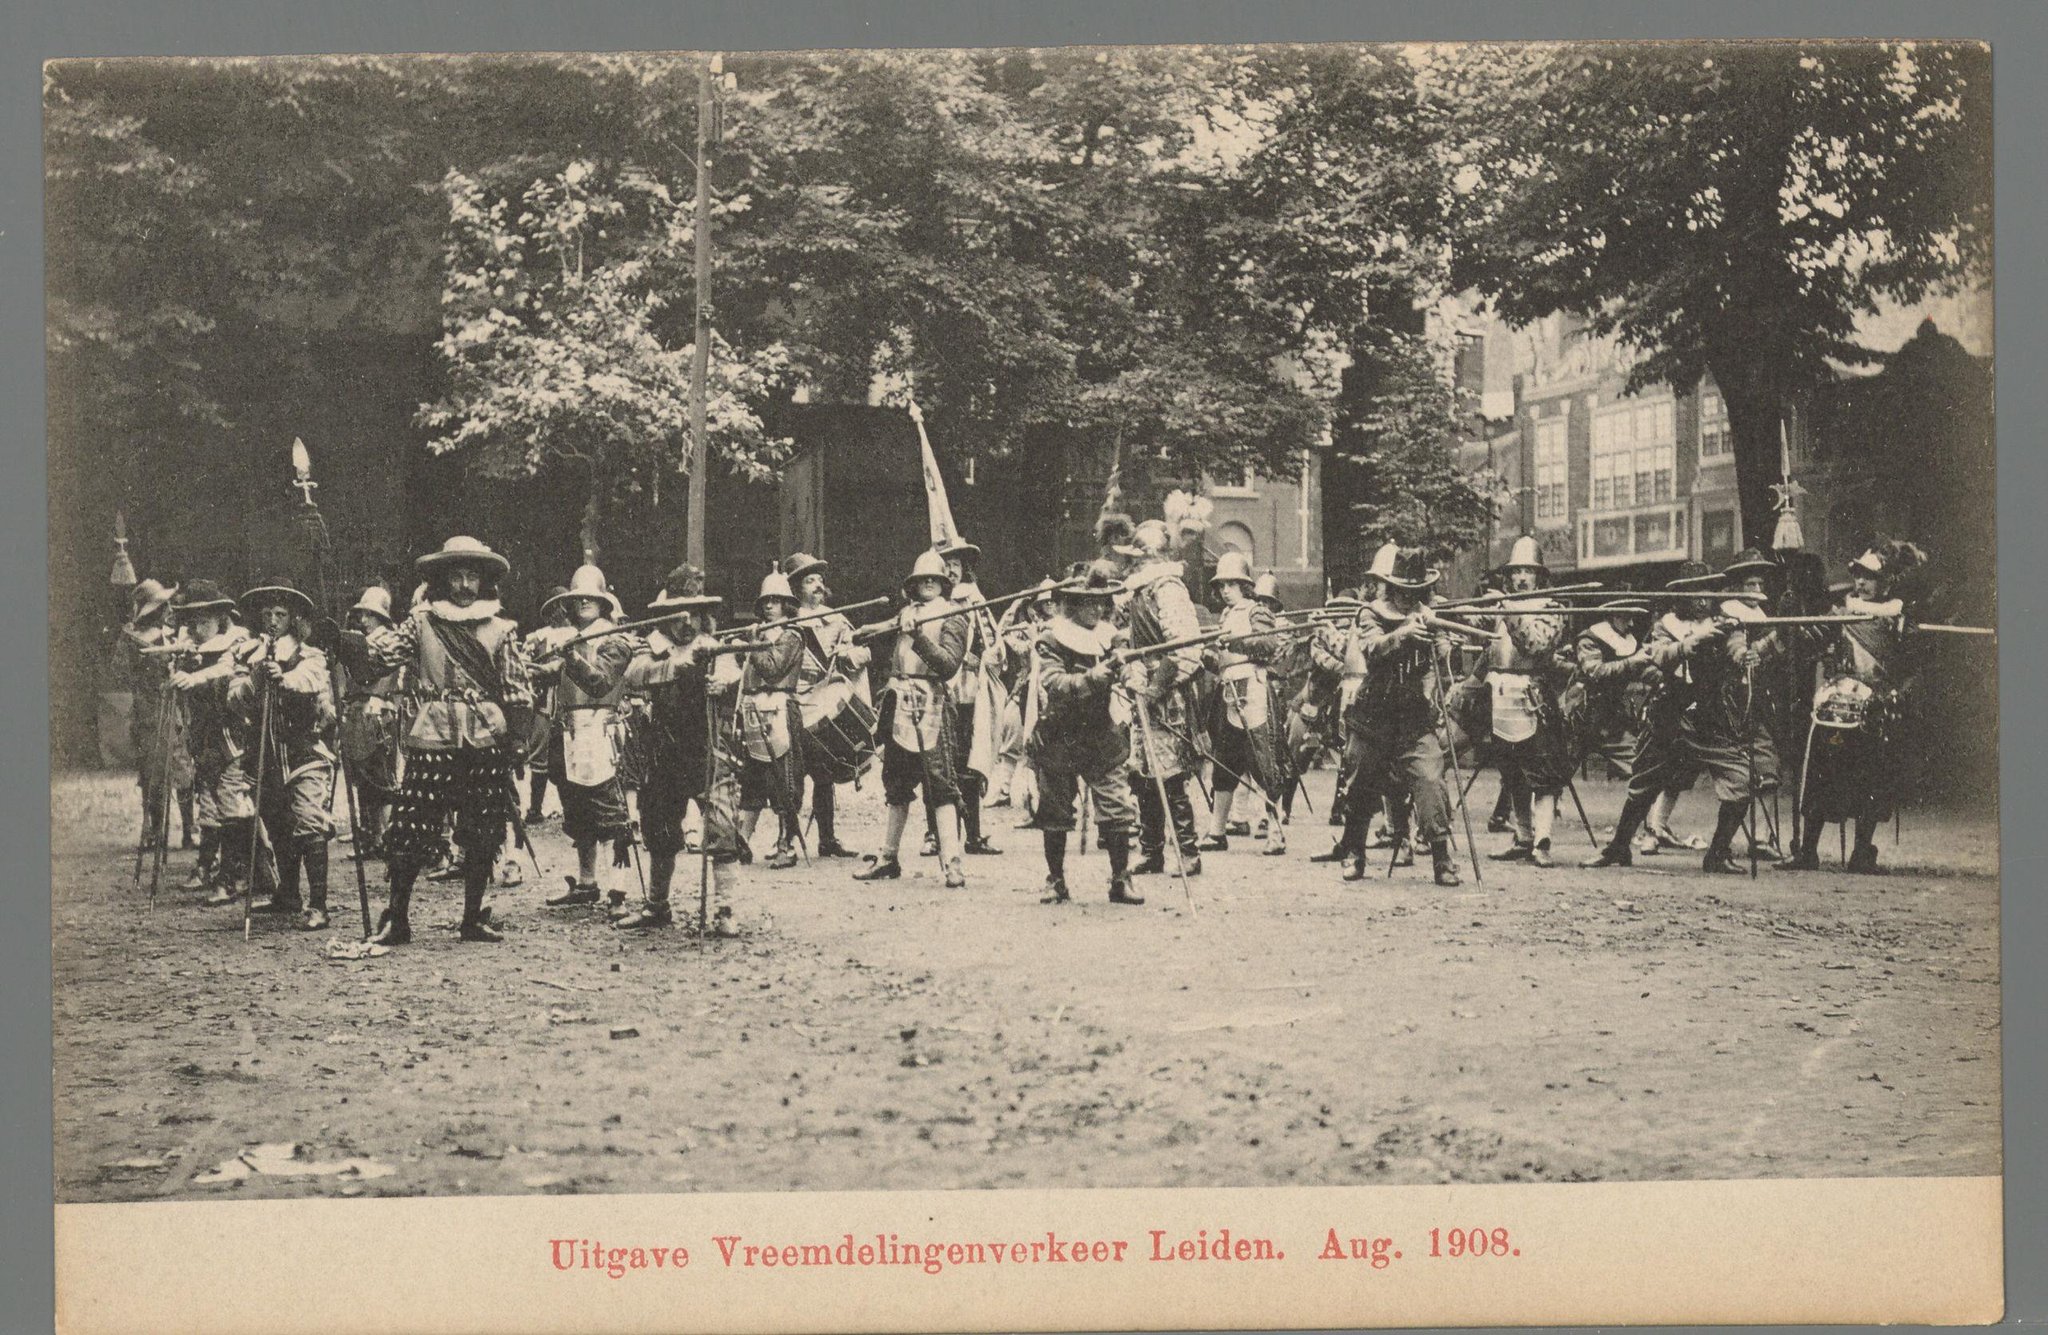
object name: photomechanical print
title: Mannen in kostuum tijdens de Oud-Hollandse feesten te Leiden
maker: Anonymous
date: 1908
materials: cardboard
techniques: photograph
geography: haarlem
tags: dress-up party, standard-bearer, flag-bearer, armour, casting weapons: spear, firearms: rifle, festivities, leiden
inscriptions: date